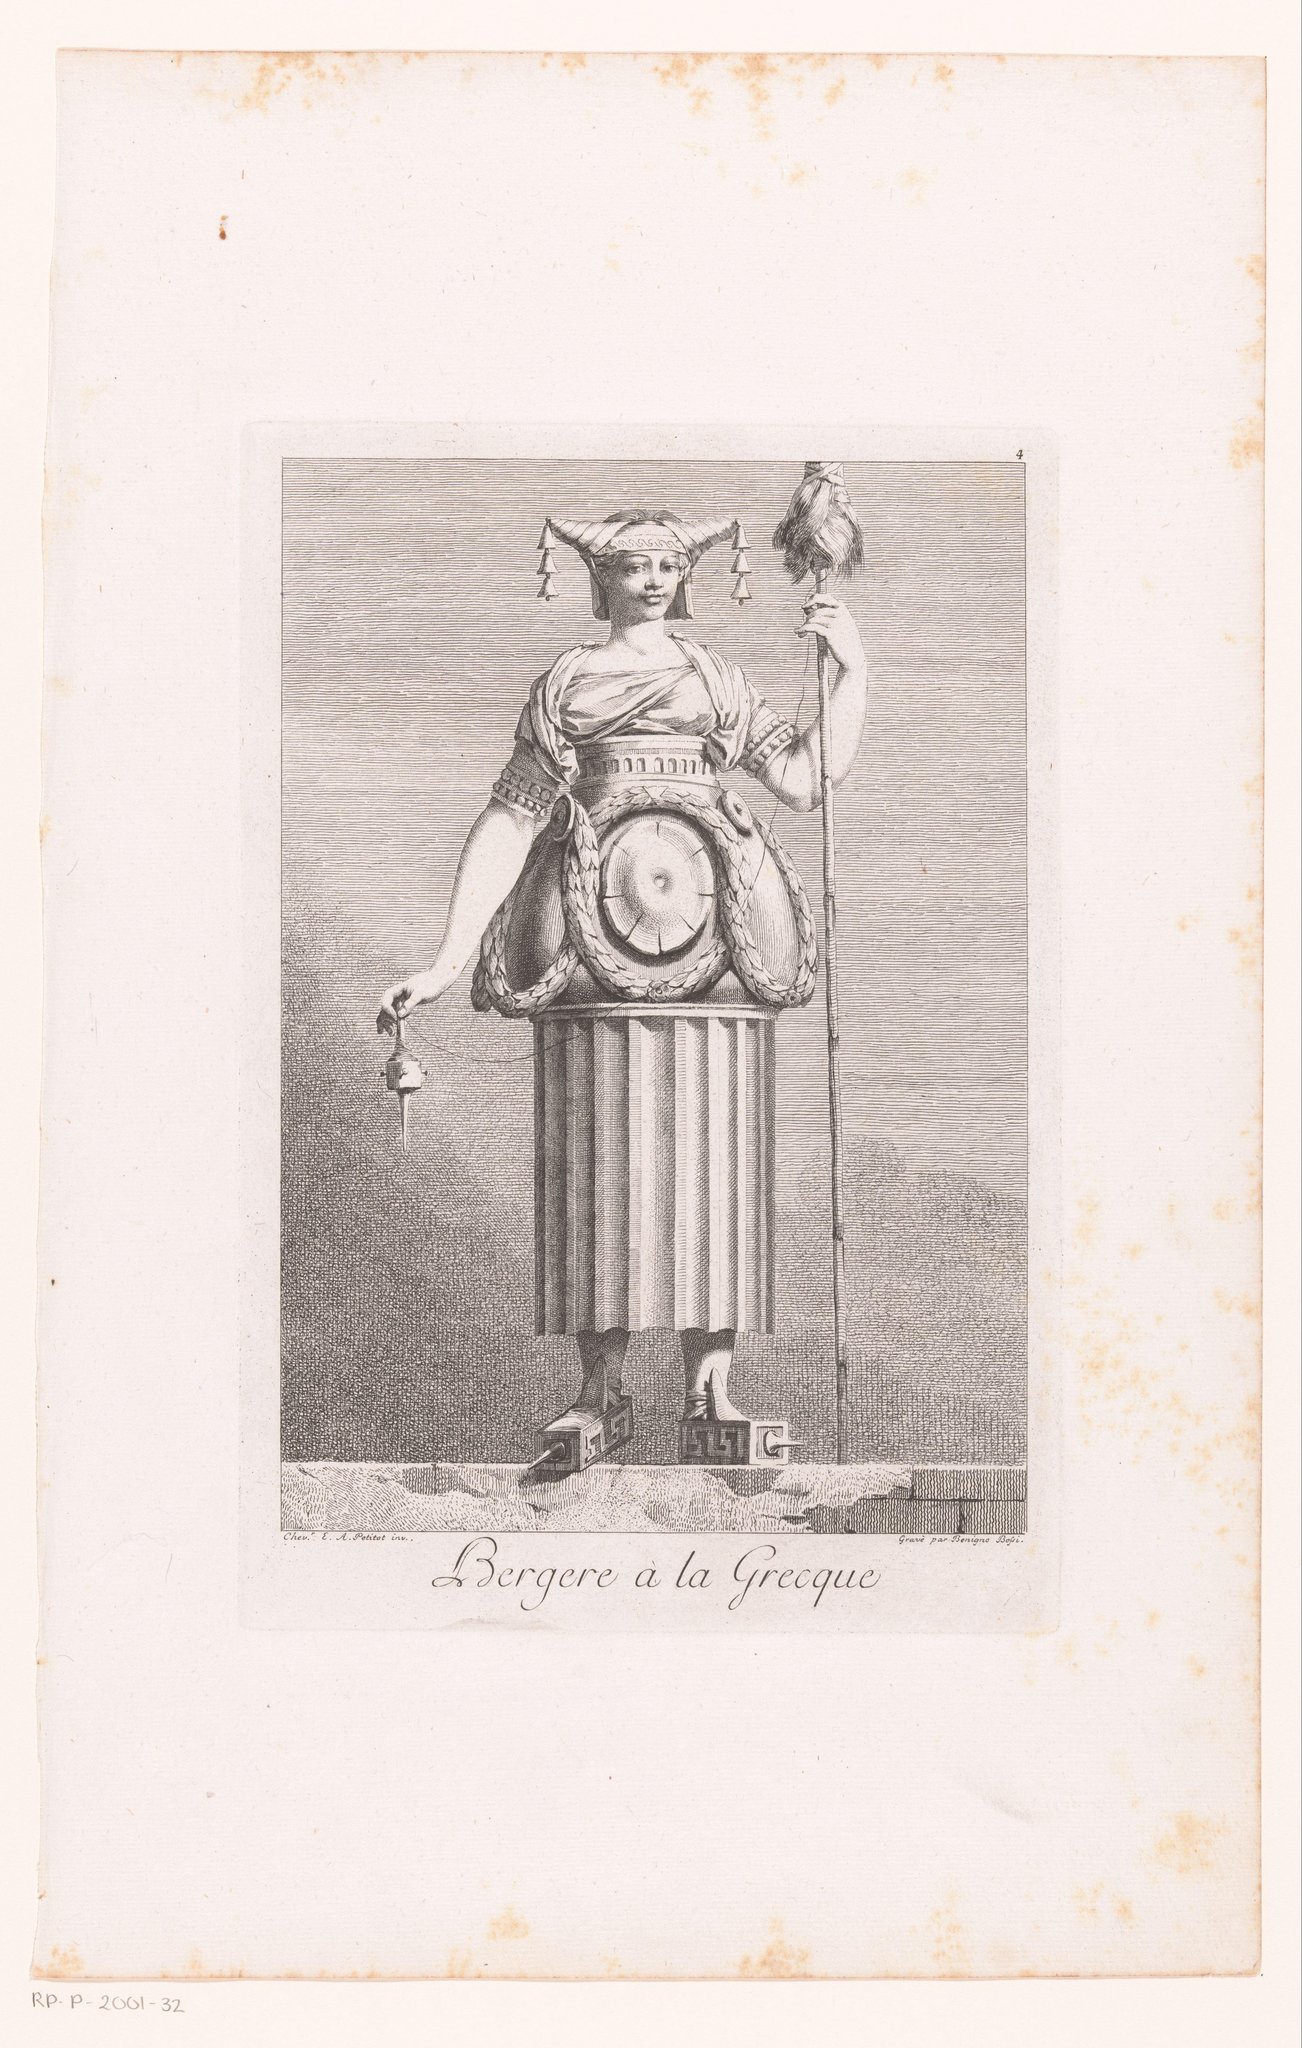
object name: print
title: Mascarade A La Grecque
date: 1771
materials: paper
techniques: etching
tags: europeans, herding, herdsman, herdswoman, shepherd, shepherdess, cowherd, etc.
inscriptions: collector's mark: Lugt 2760, collector's mark: Lugt 2228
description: Een staande vrouw met een onderlijf als een gecanneleerde zuil. Rondom haar middel een rond element en guirlandes. In haar handen houdt zij een spinrokken en op haar hoofd draagt zij een hoofddeksel met twee punten met ieder drie bellen.